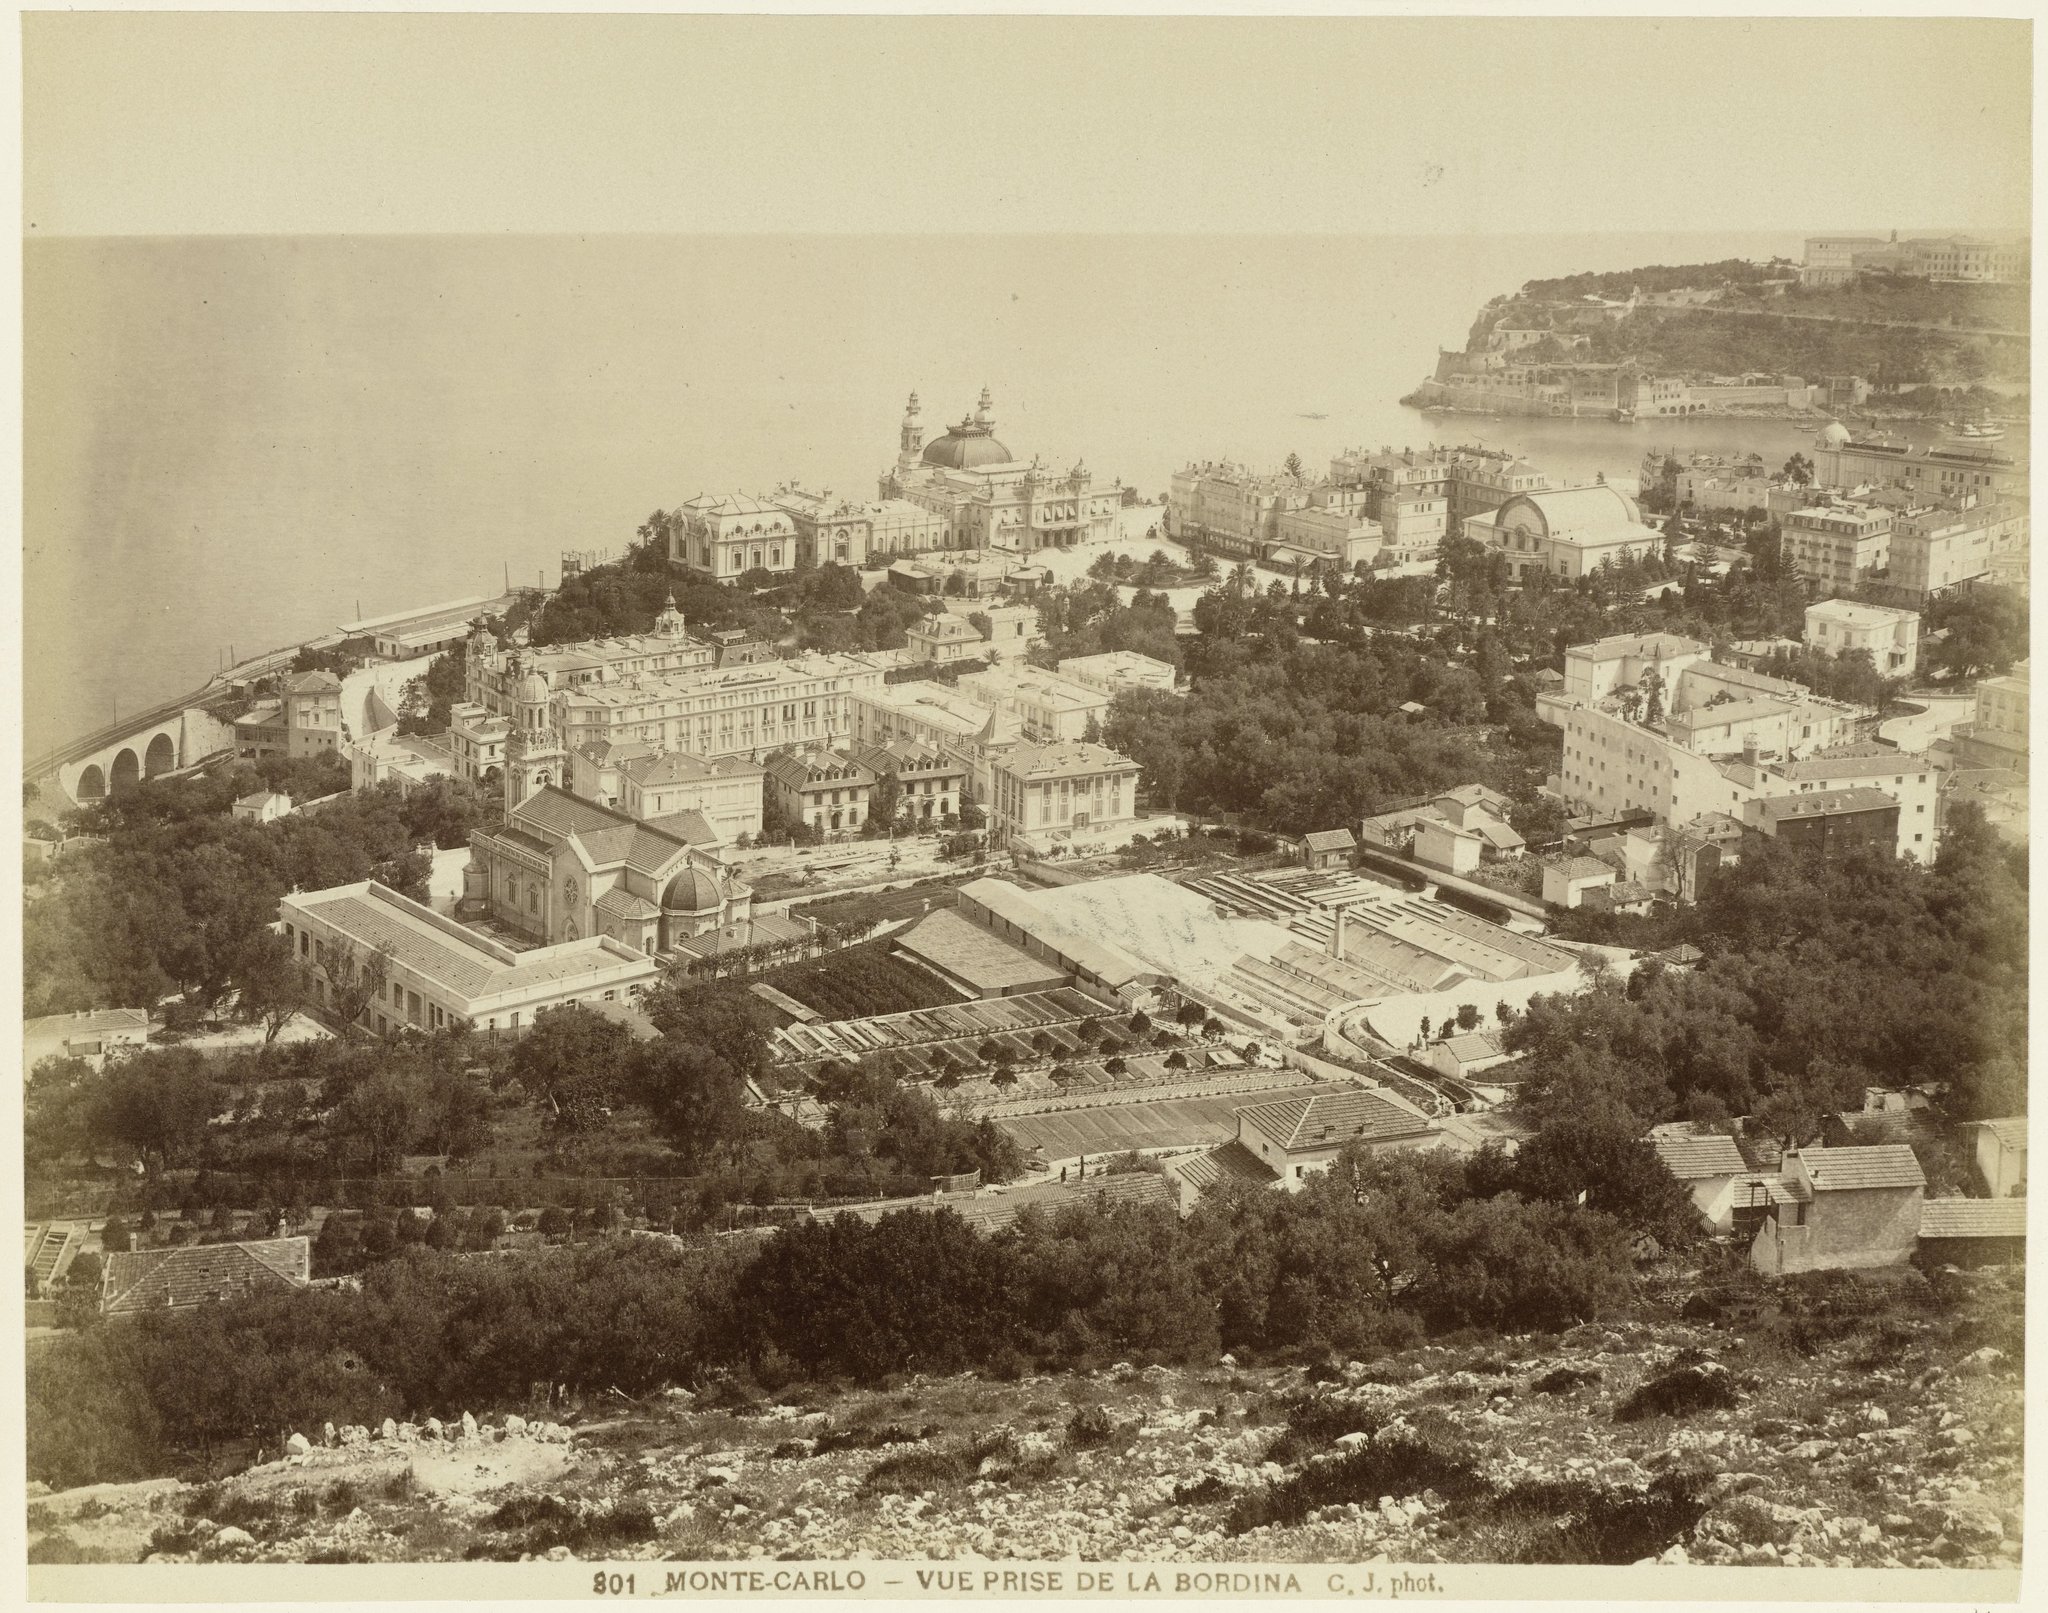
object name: photograph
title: Gezicht op de stad van Monte Carlo gelegen aan zee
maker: henry pauw van wieldrecht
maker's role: fotograaf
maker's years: 1863-1912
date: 1886-1896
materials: cardboard, photographic support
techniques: albumen print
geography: france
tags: monte carlo